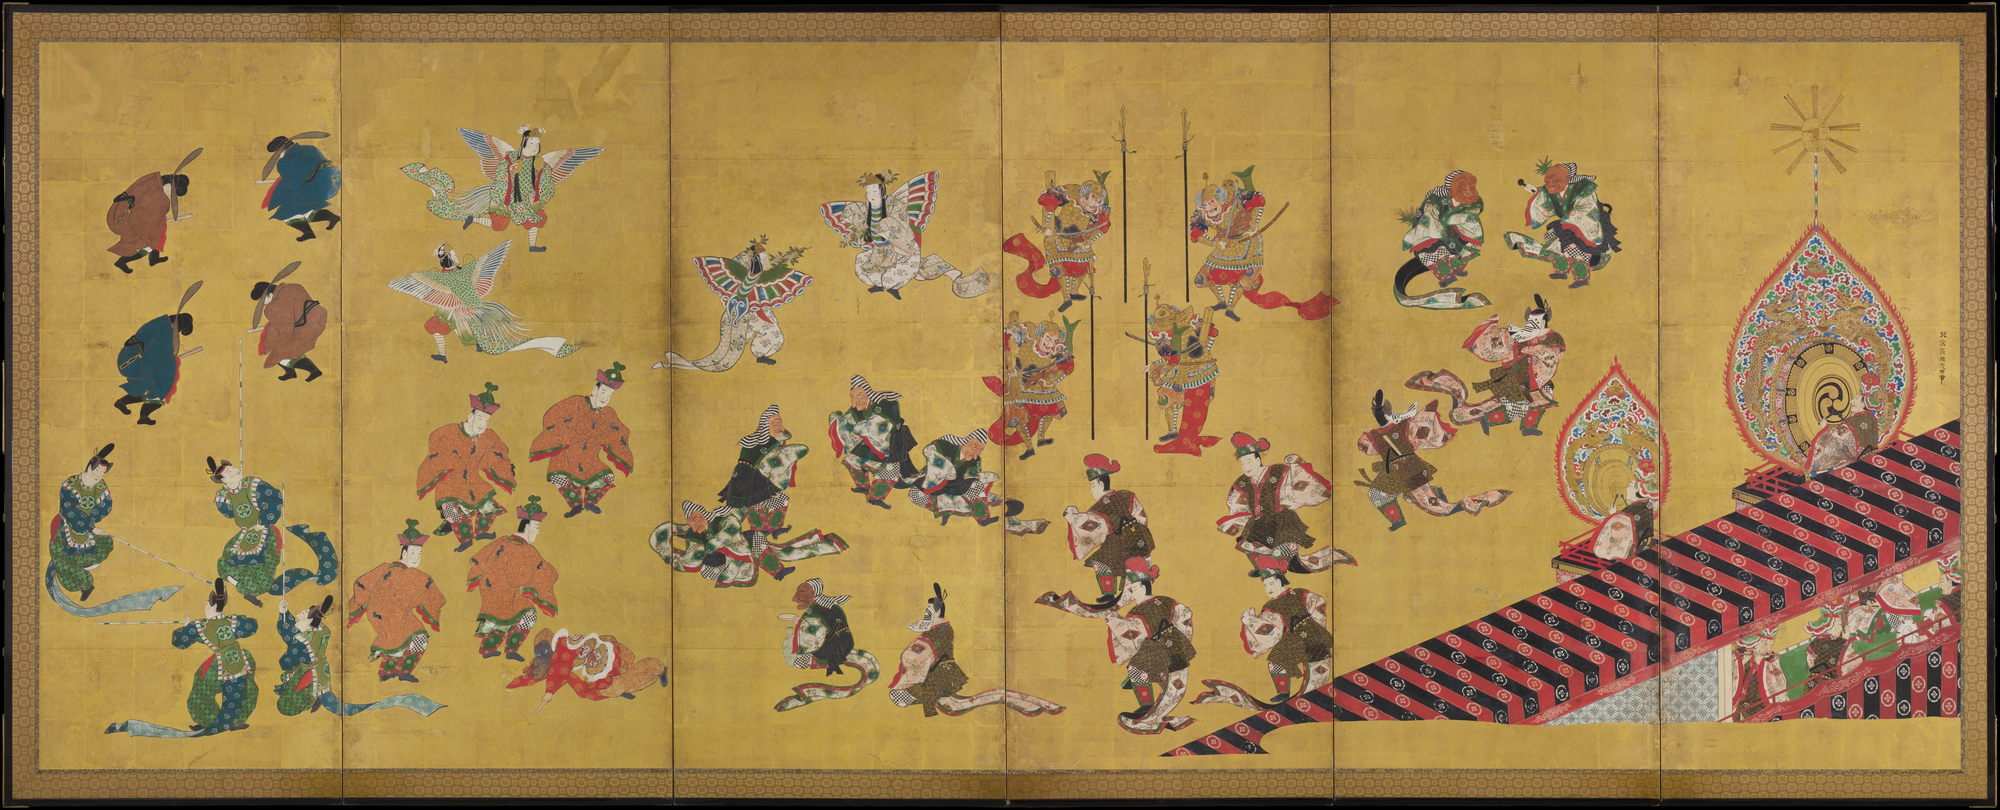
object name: screen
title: Bugaku Dances (front); Chinese Lions (reverse)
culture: japanese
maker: hanabusa itchō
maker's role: artist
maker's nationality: japanese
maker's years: 1652-1724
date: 1701-1733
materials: gold leaf, ink, panel, paper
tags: human figures,dance,lions